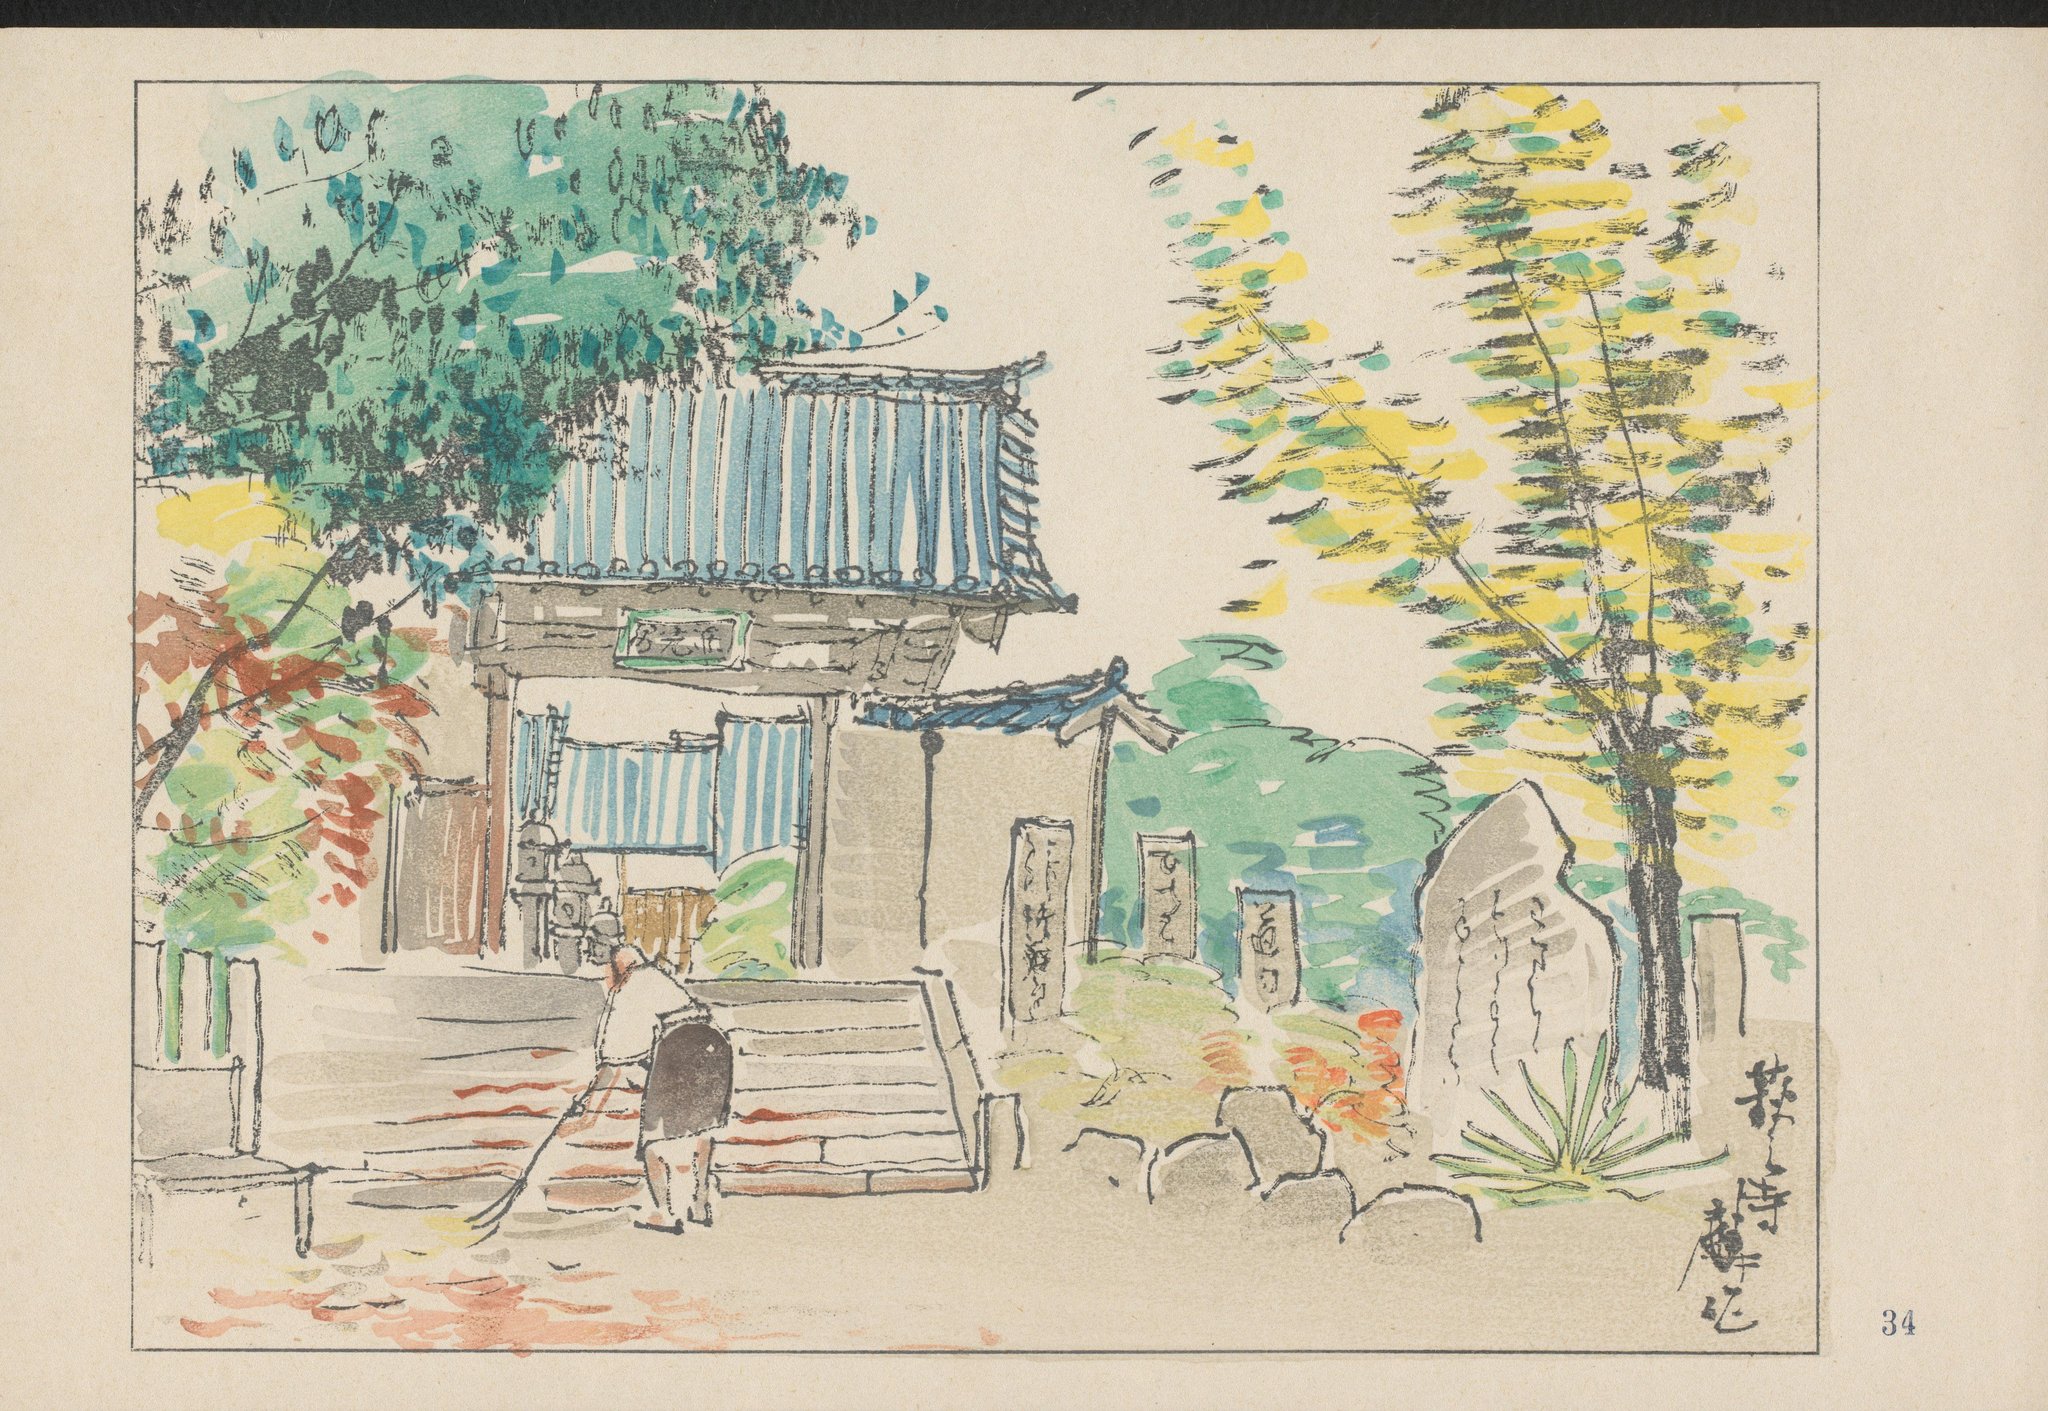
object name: print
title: Haginotera, the temple of bush clovers.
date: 1947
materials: paper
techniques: woodcut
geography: japan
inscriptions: date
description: Gezicht op de ingang van de tempel Haginotera, waar een monnik de trap schoonveegt.